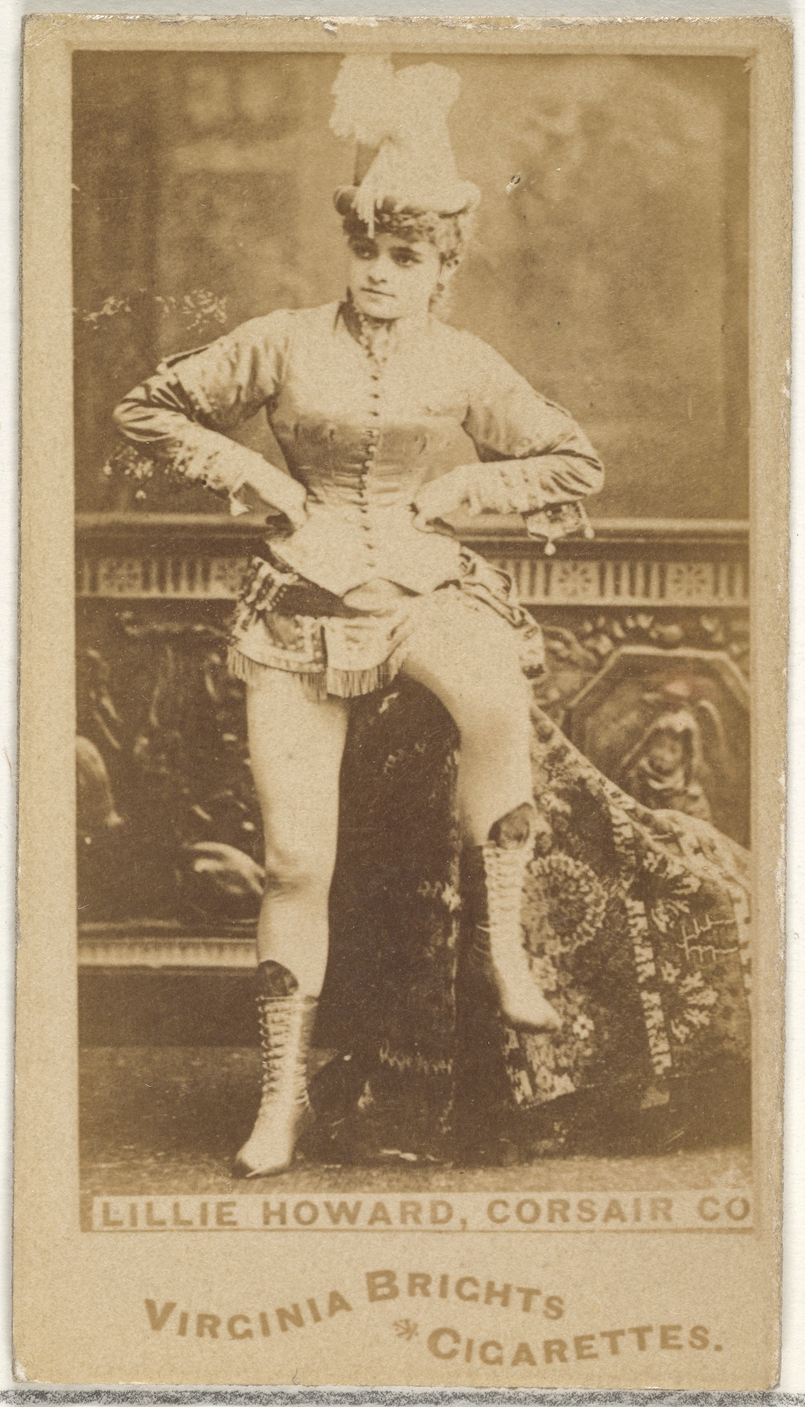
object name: photograph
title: Lillie Howard, Corsair Co., from the Actors and Actresses series (N45, Type 1) for Virginia Brights Cigarettes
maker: allen & ginter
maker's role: publisher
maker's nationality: american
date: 1888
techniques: albumen silver print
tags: portraits,women,actresses